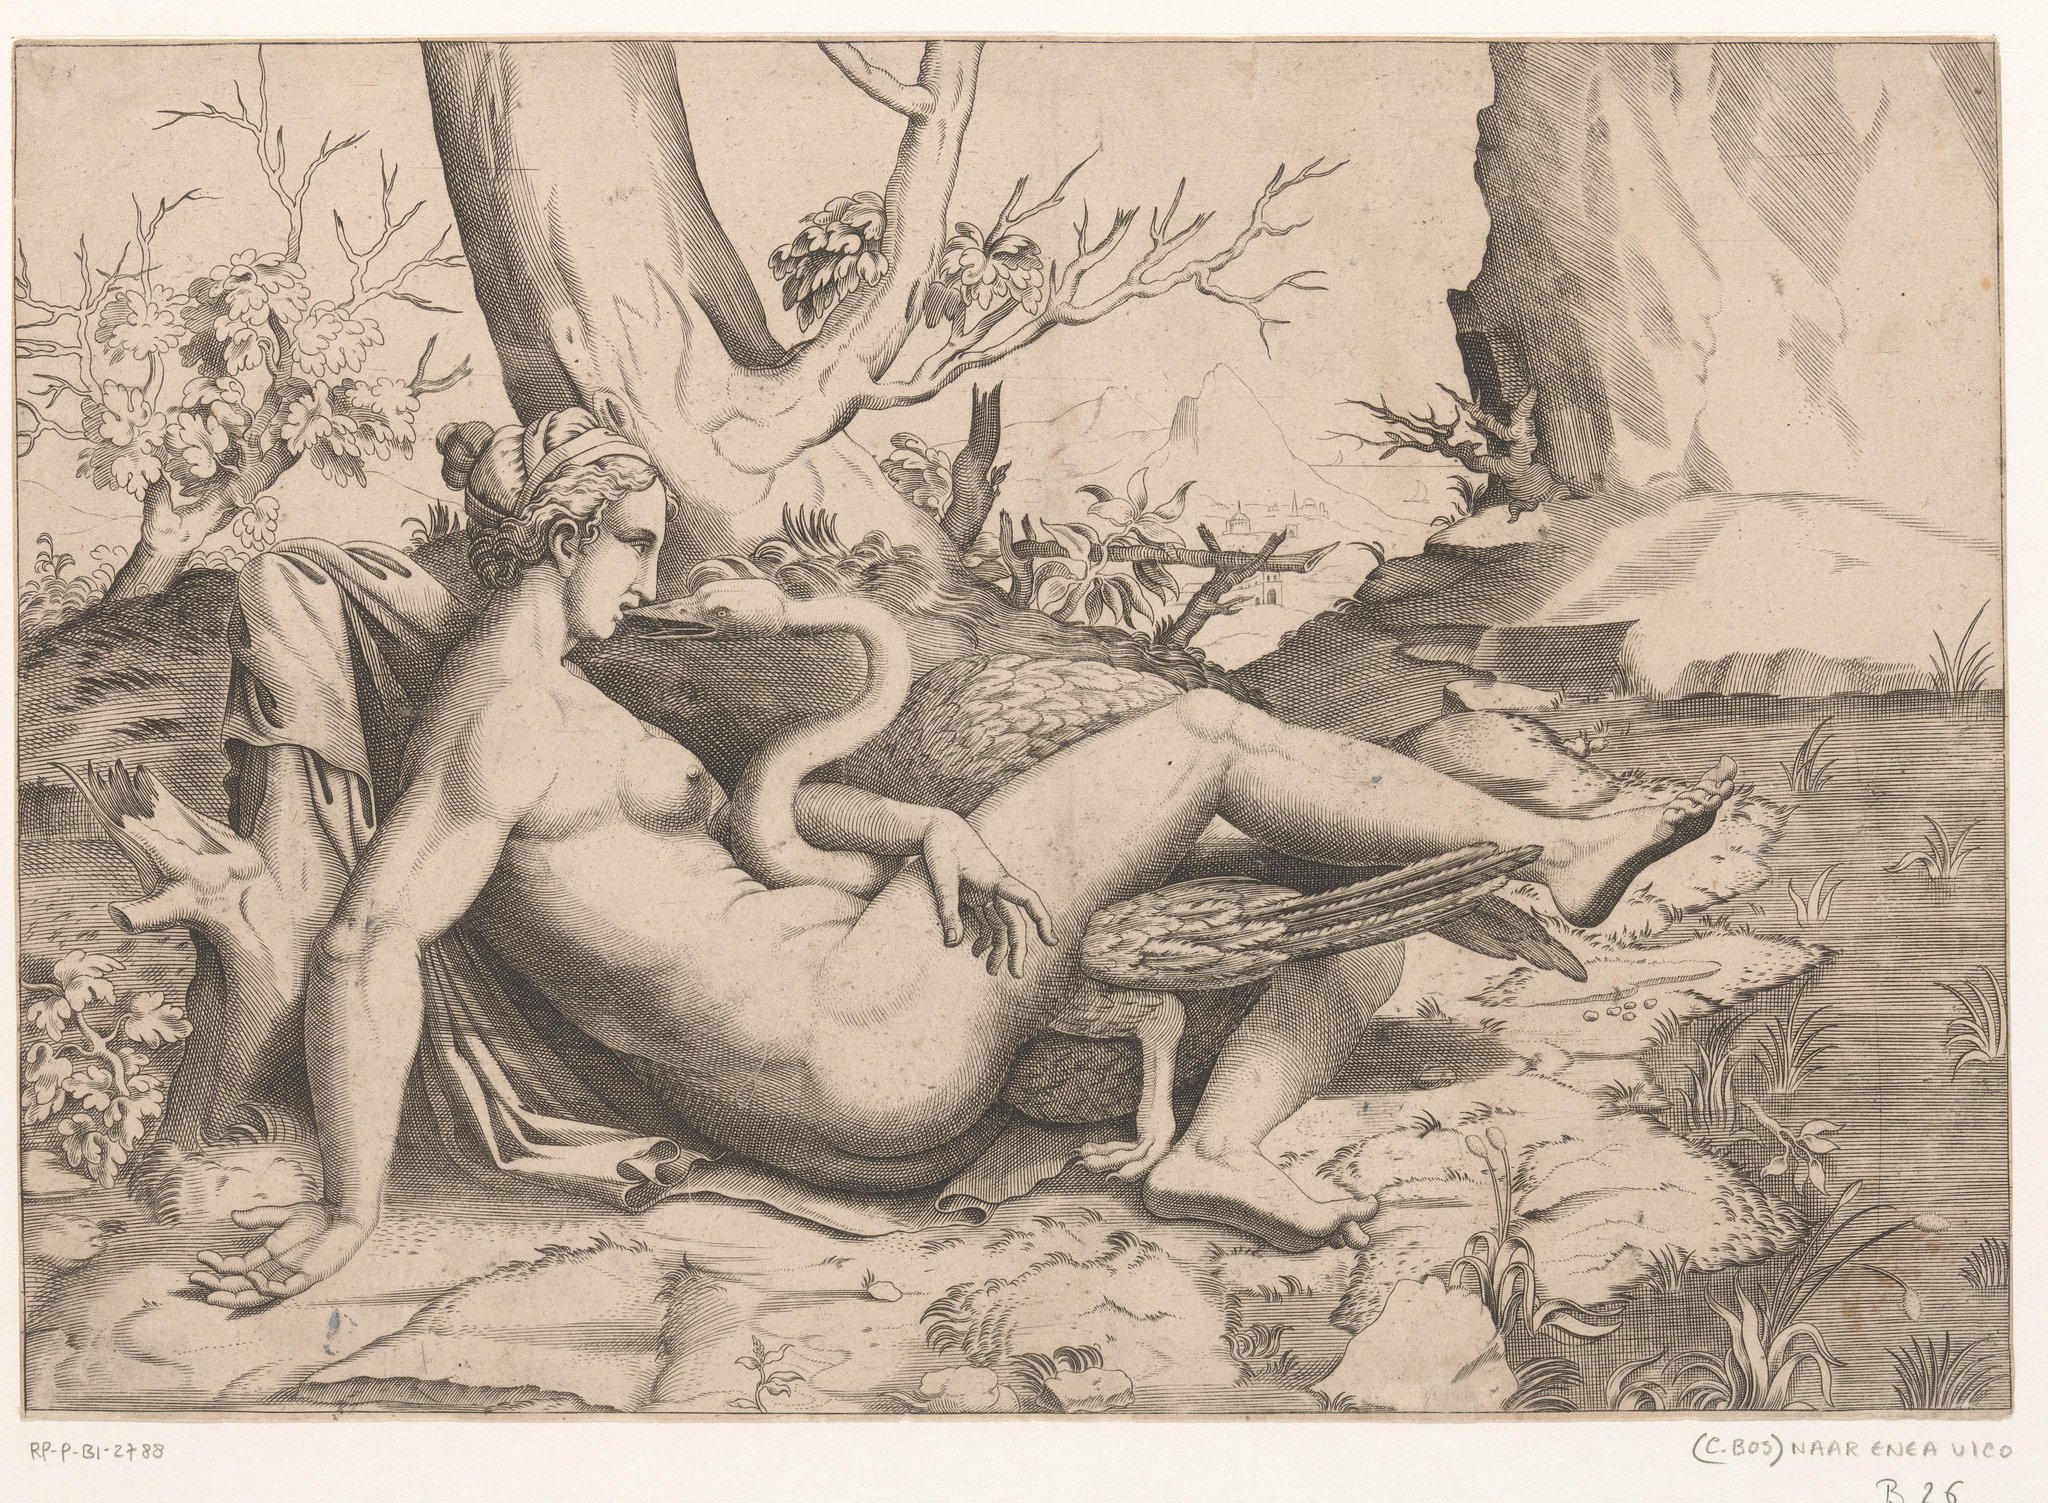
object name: print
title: Leda en de zwaan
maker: cornelis bos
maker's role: print maker, printer, publisher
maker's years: 1510-1566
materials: paper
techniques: engraving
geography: italy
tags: jupiter, in the shape of a swan, and leda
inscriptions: collector's mark: Lugt 240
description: De naakte Leda ligt op een doek op de grond. Tussen haar benen Jupiter in de gedaante van een zwaan. Rechts een rivier.